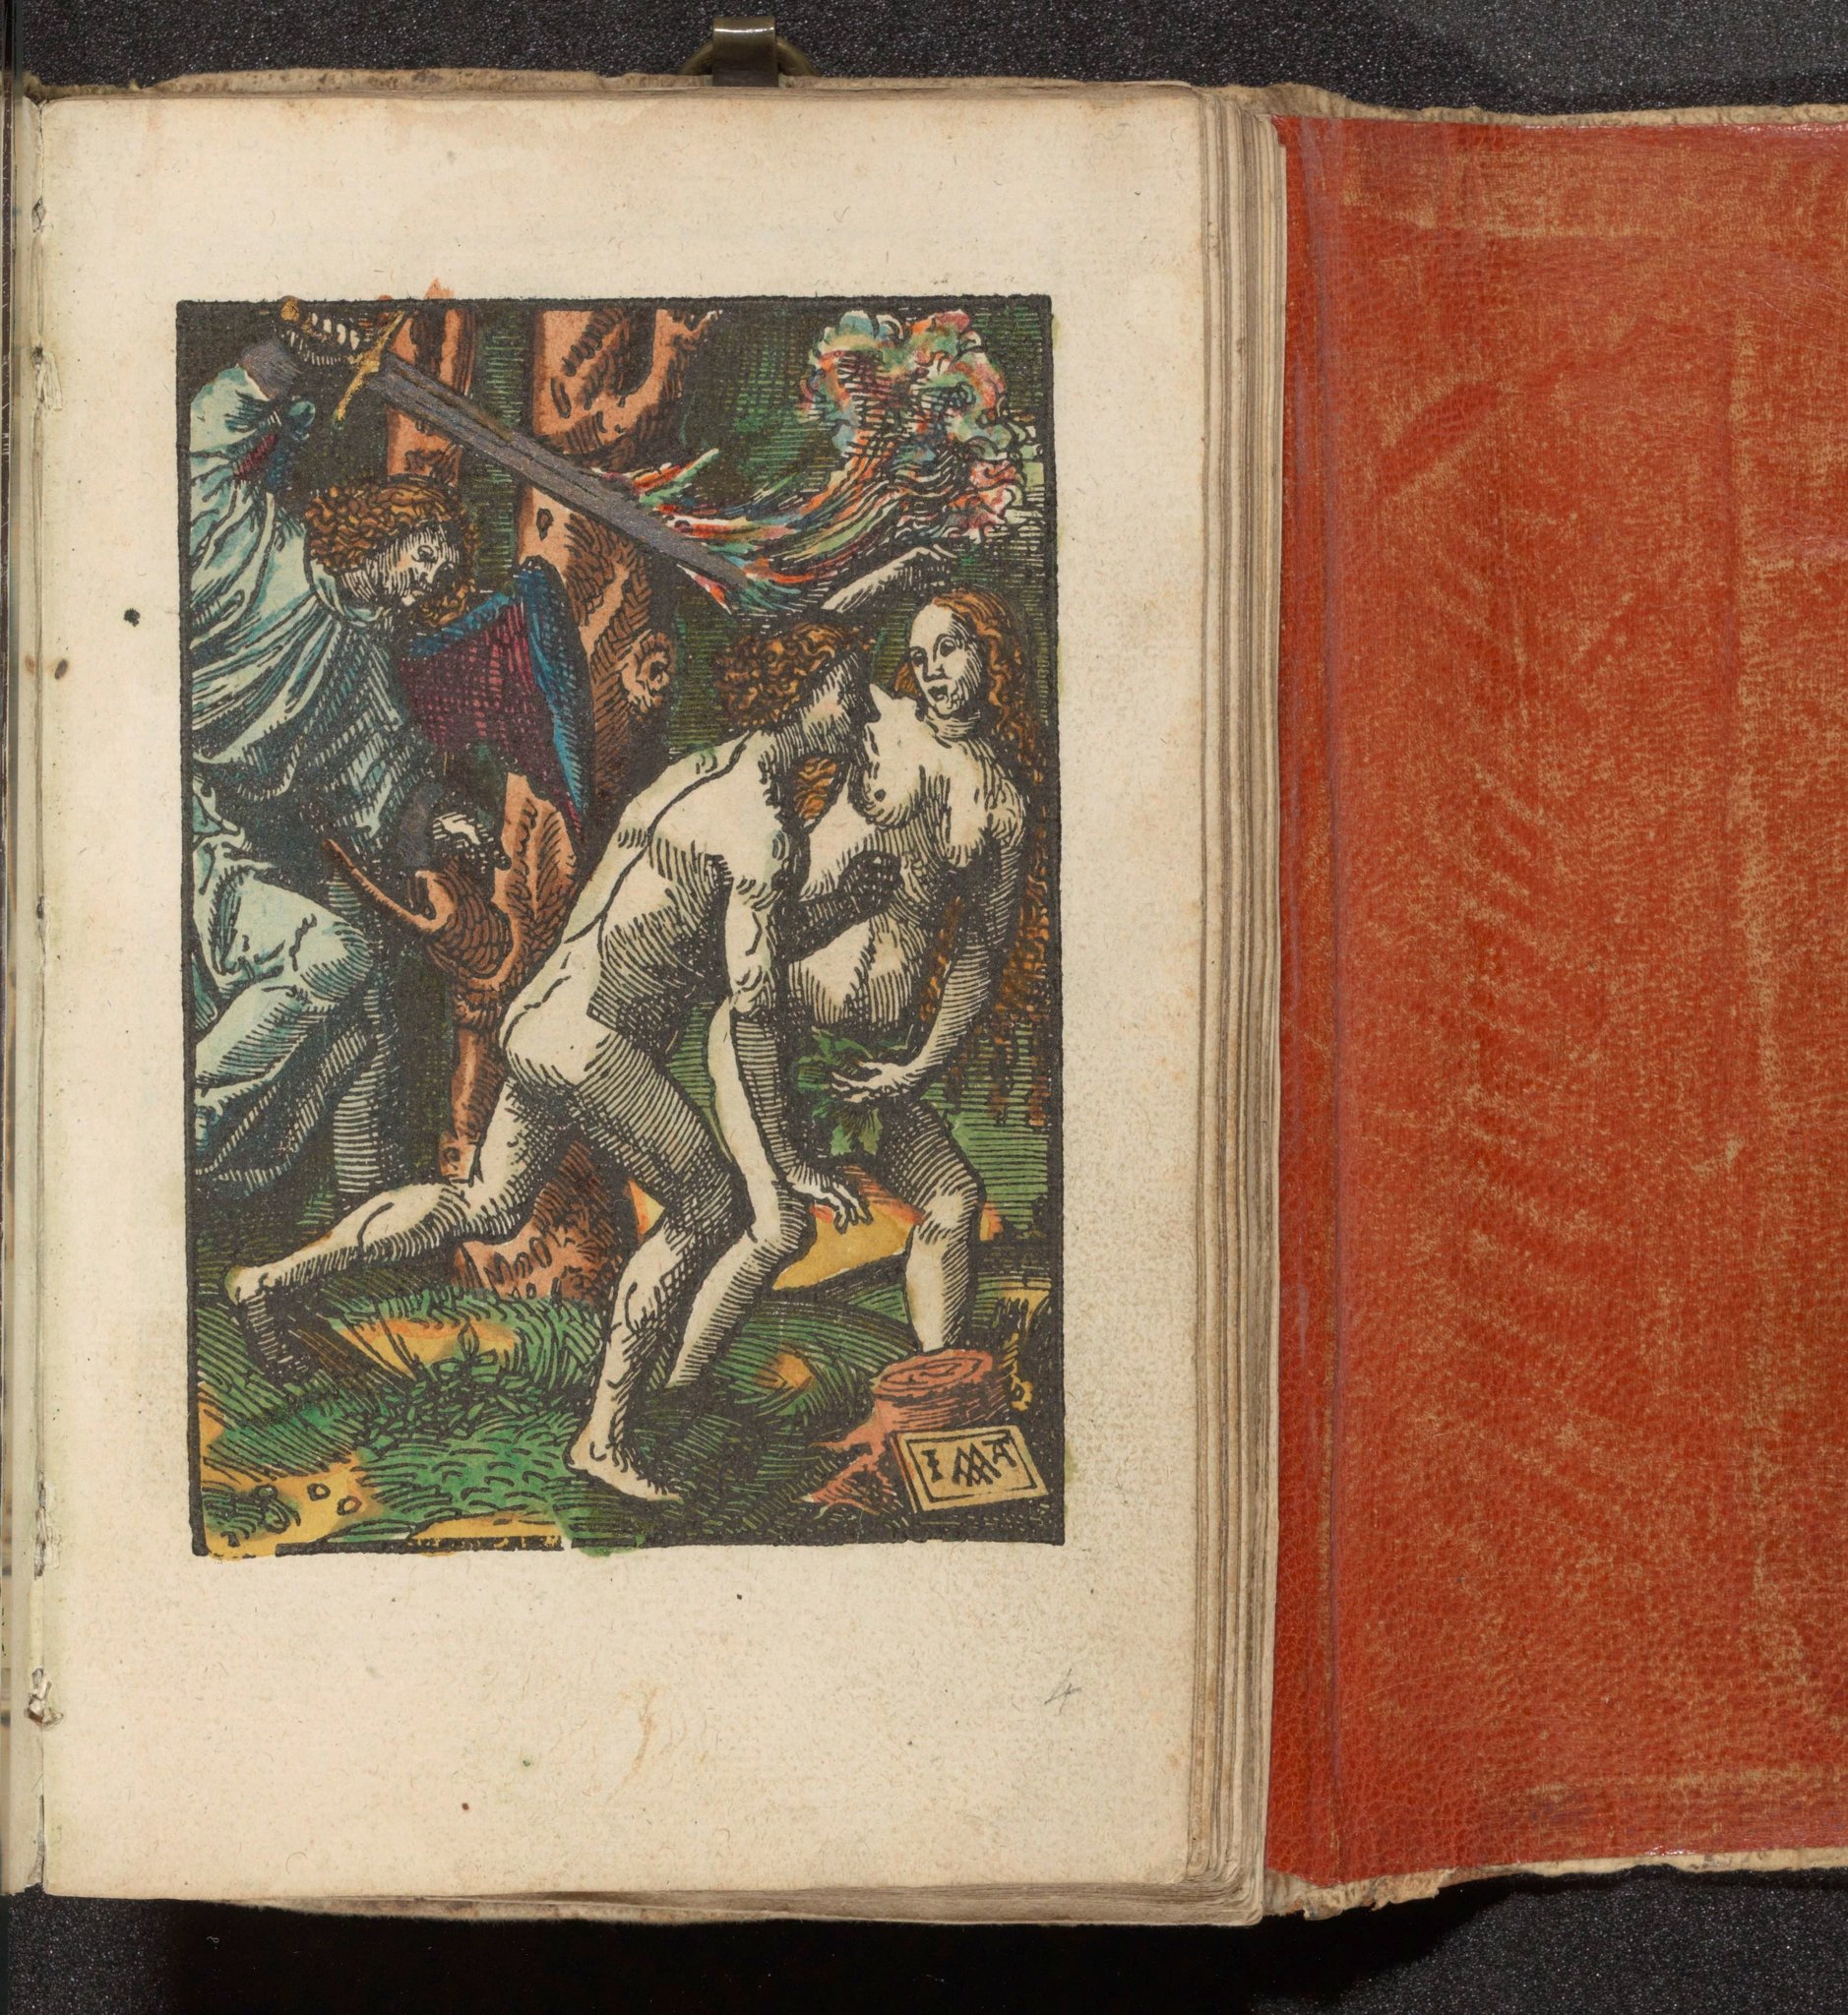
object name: album leaf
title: De kleine Passie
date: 1520-1521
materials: paper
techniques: hand coloring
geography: amsterdam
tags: book in which illustrations are essential, an angel chases adam and eve out of paradise with a (flaming) sword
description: Adam en Eva worden door een engel met een vlammend zwaard uit het paradijs verdreven. Prent maakt deel uit van een boek.